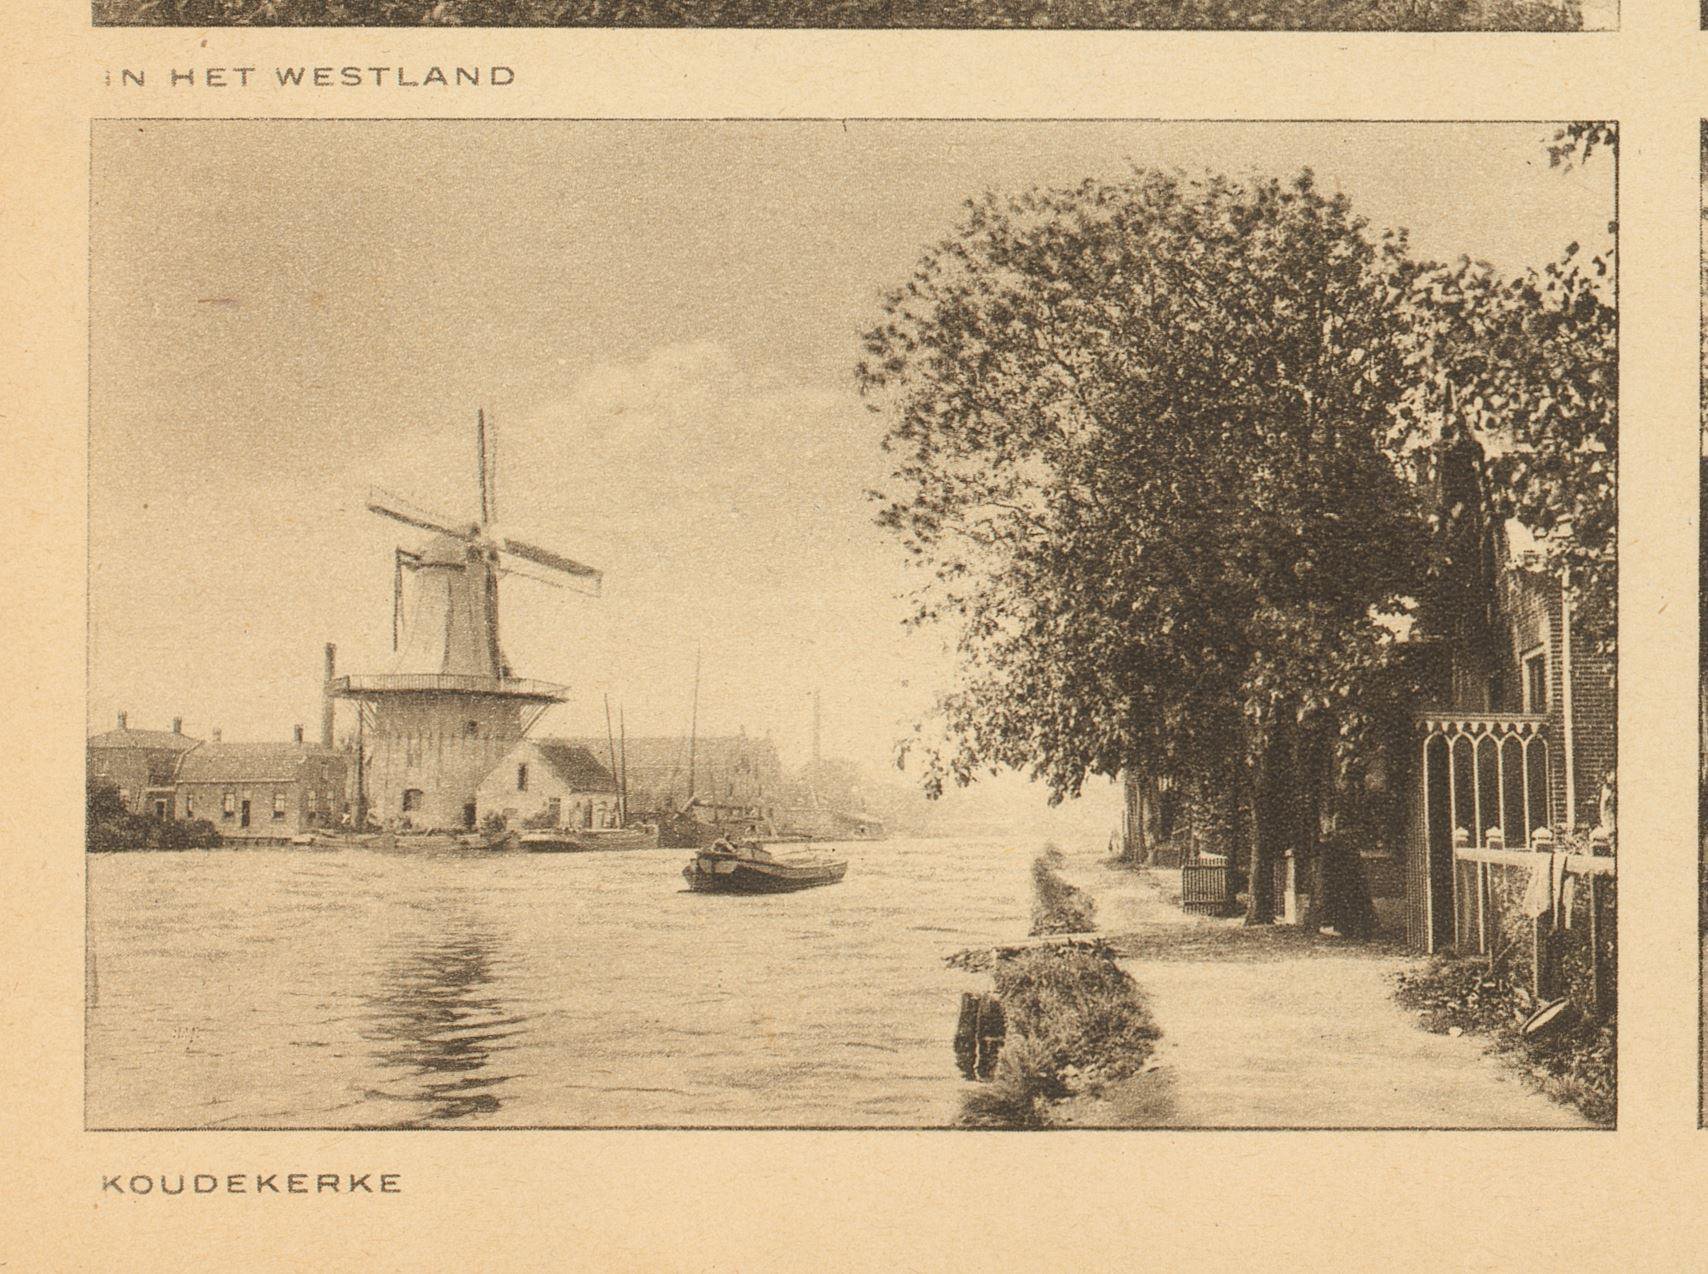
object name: album leaf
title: Koudekerke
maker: Anonymous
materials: paper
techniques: rotogravure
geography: koudekerke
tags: prospect of village, silhouette of village, canals, waters (in city)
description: Deze prent maakt deel uit van een album.